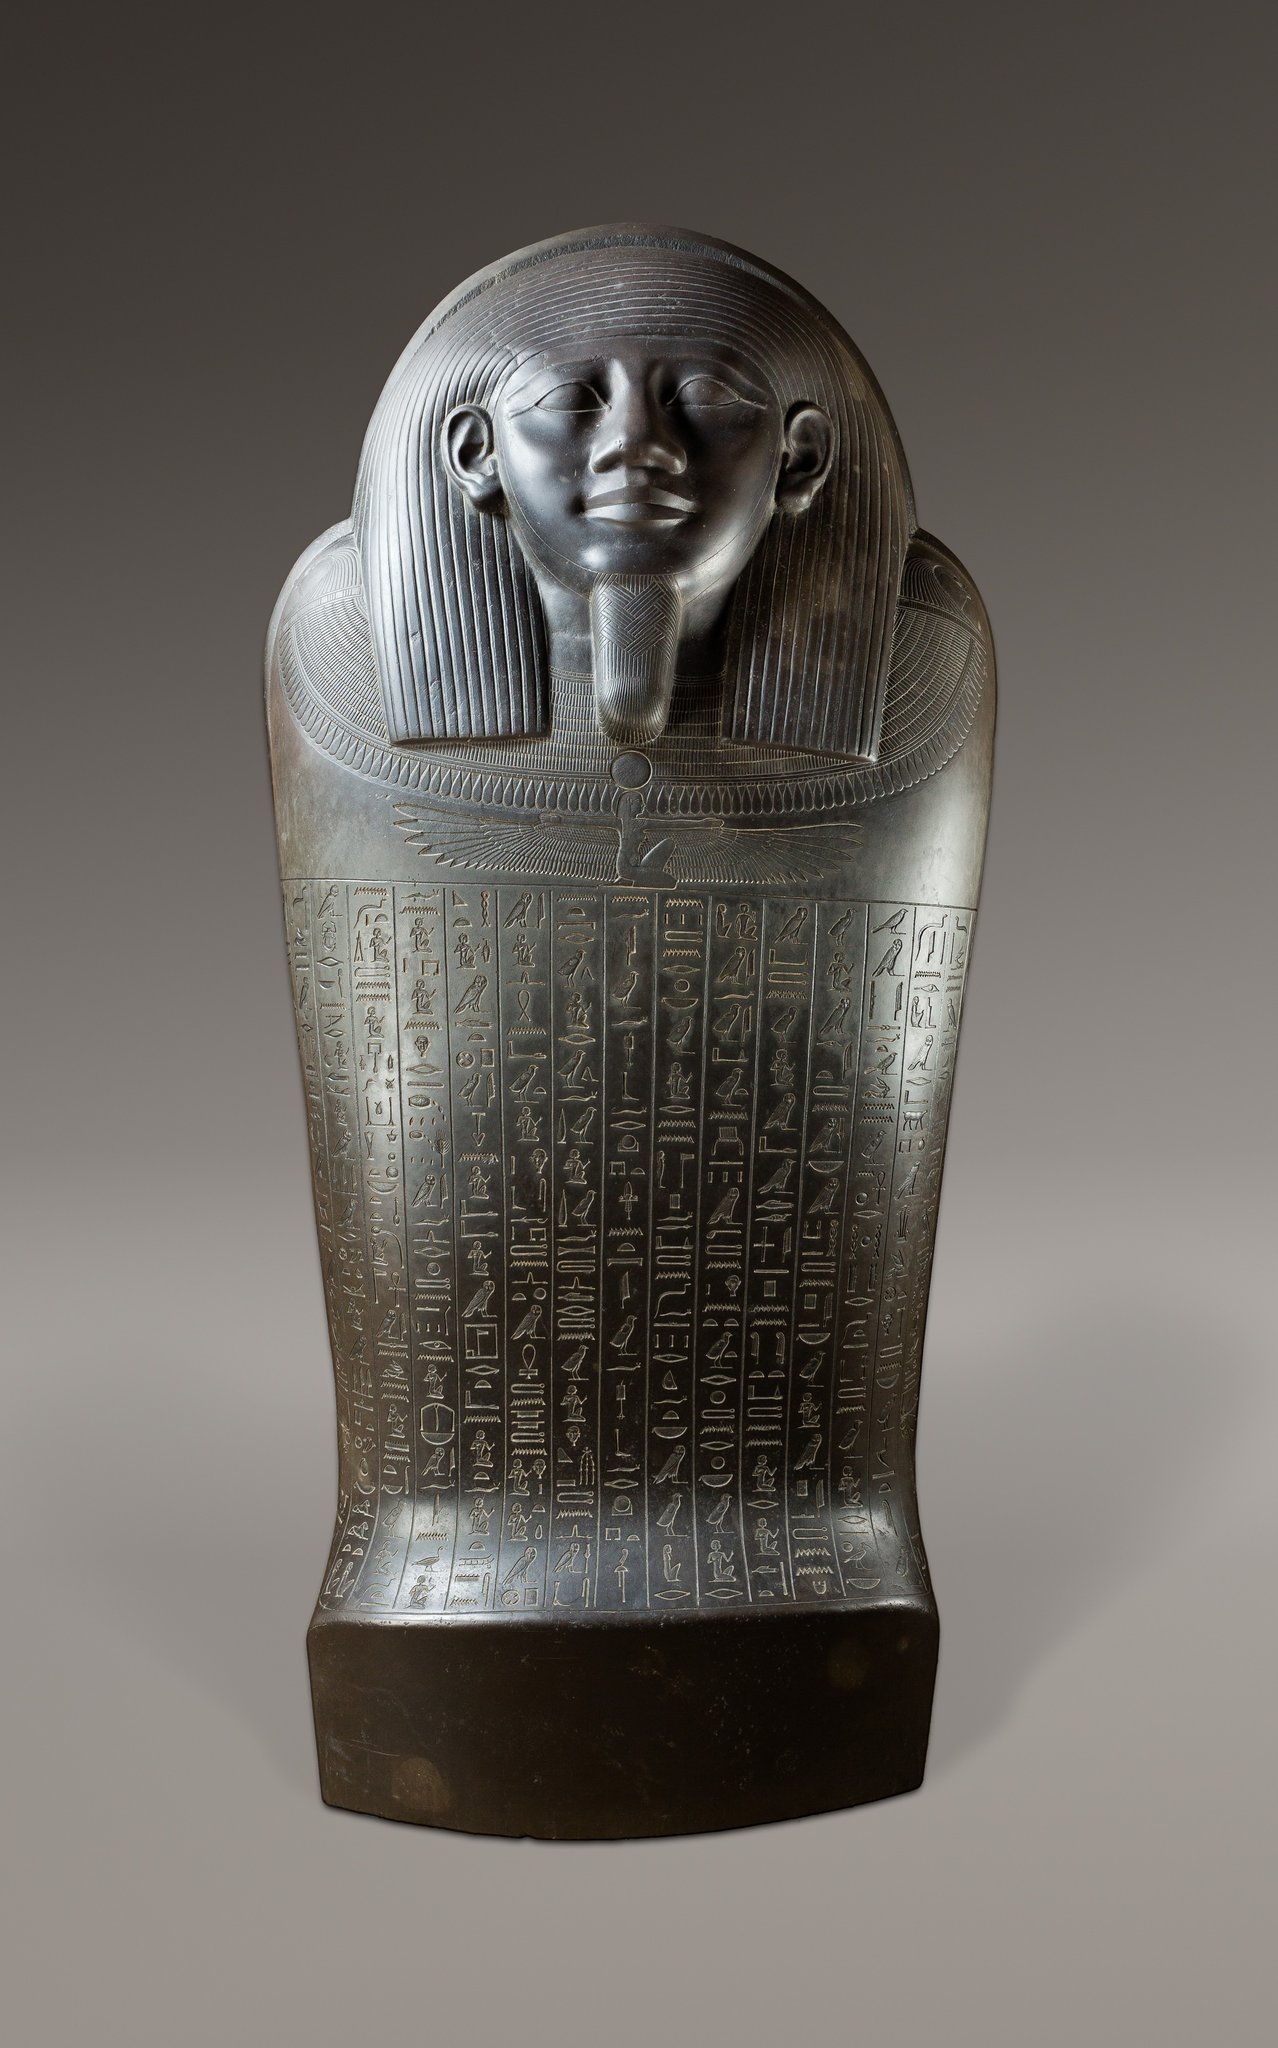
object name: sarcophagus, harkhebit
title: Sarcophagus of Harkhebit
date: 595-526 BCE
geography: egypt